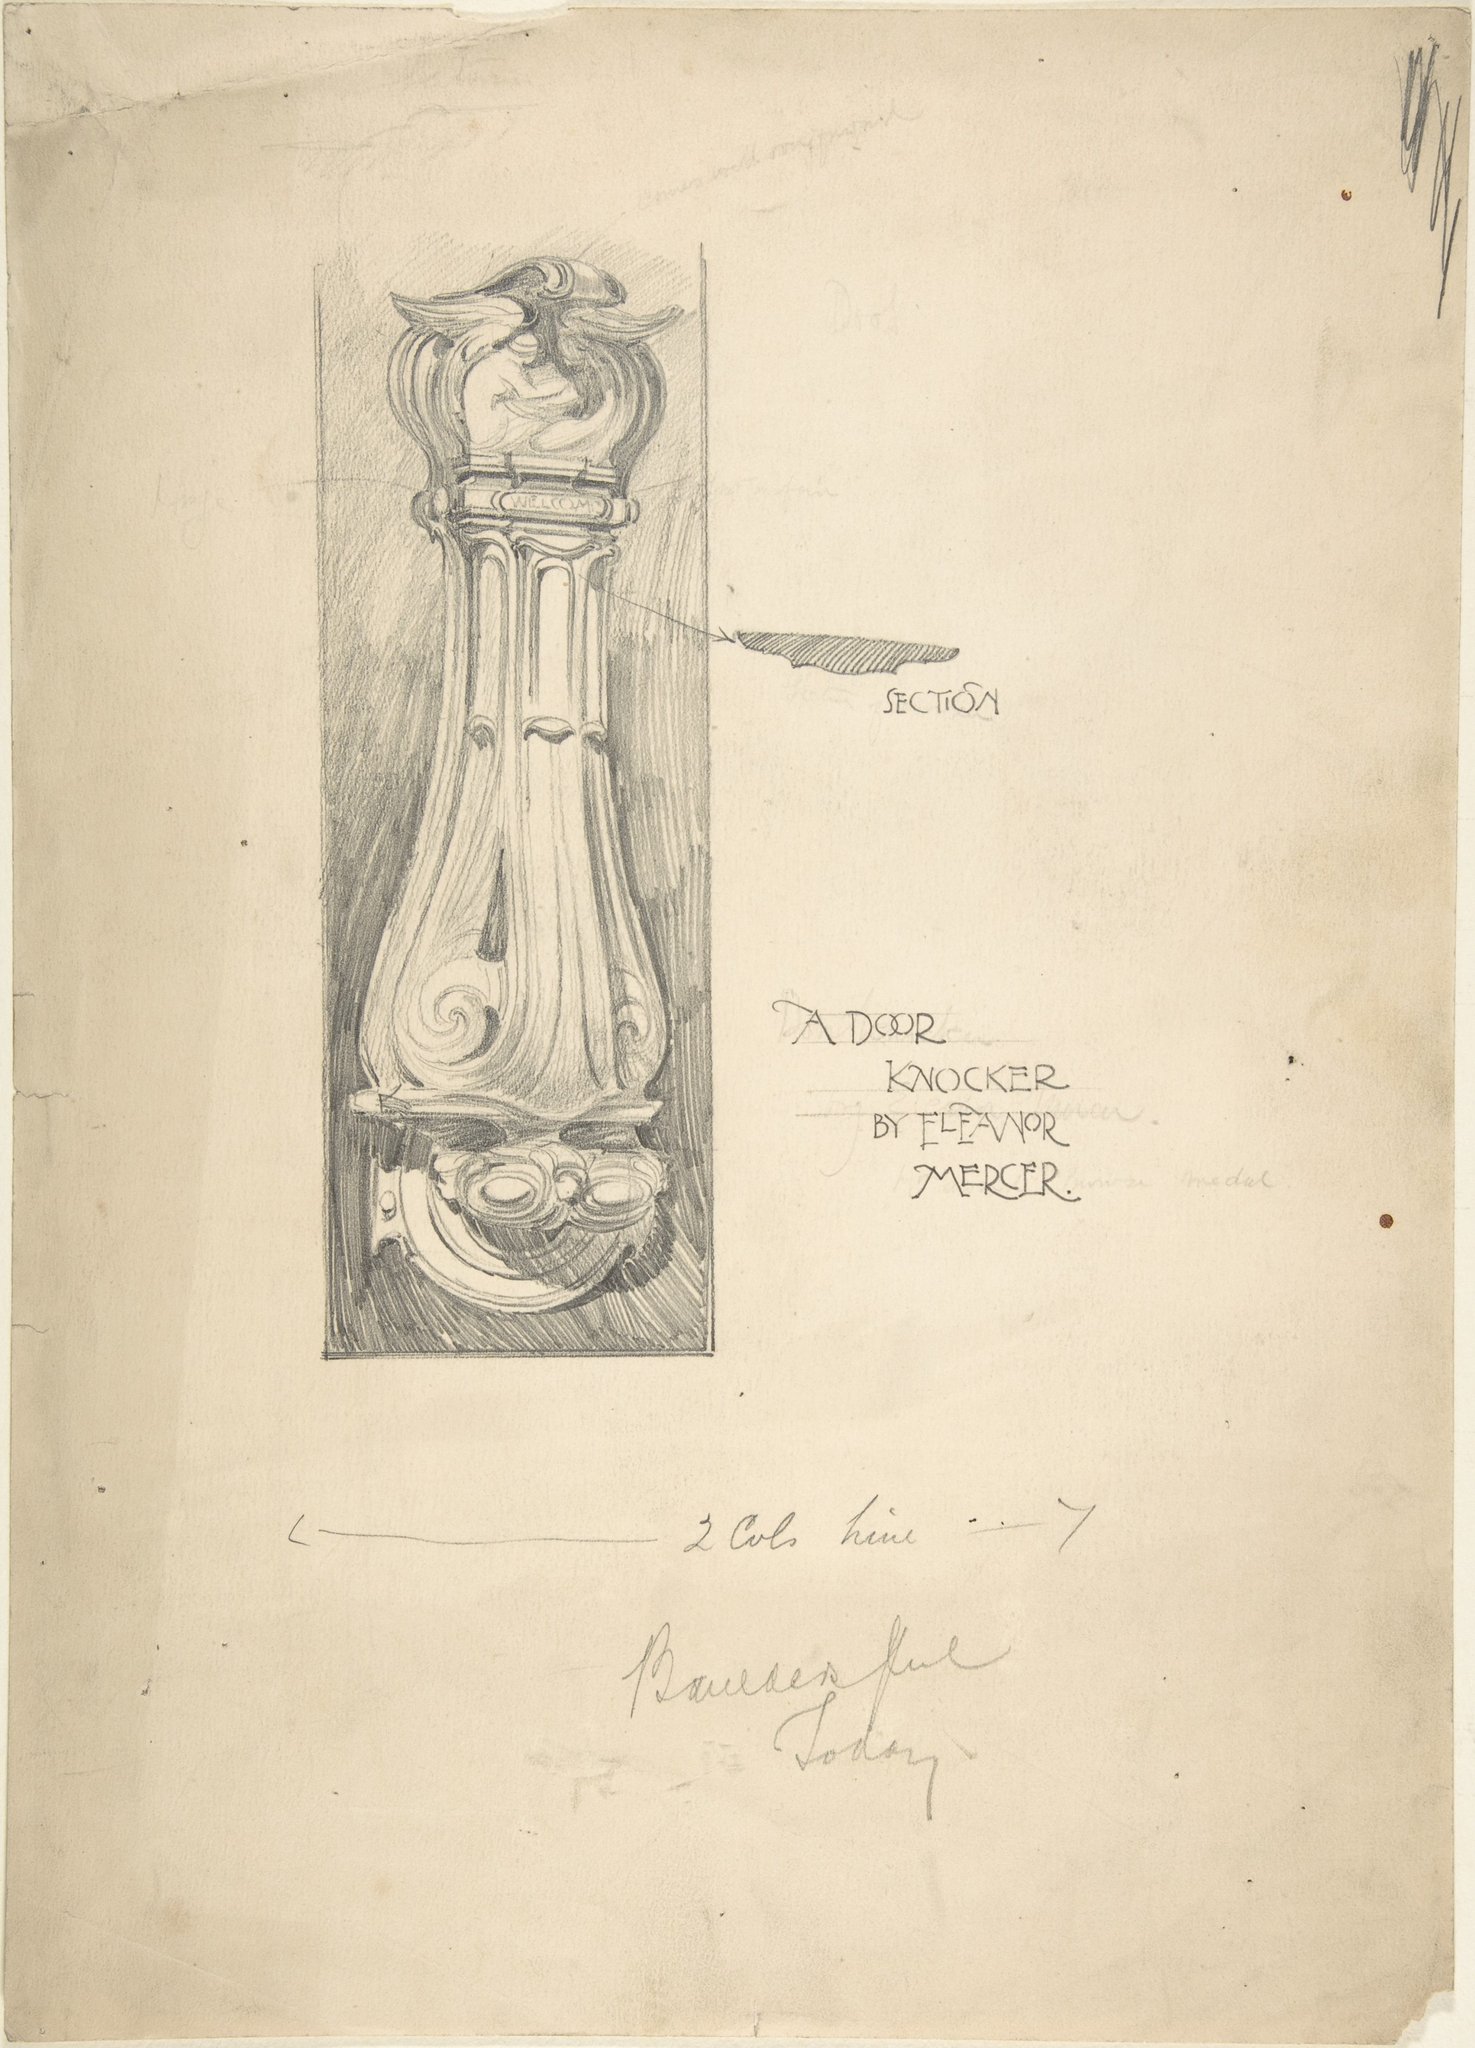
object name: drawing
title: Design for Door Knocker, for "The Builder's Journal"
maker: eleanor mercer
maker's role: artist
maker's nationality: british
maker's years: 1850-1900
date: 1886-1896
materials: graphite